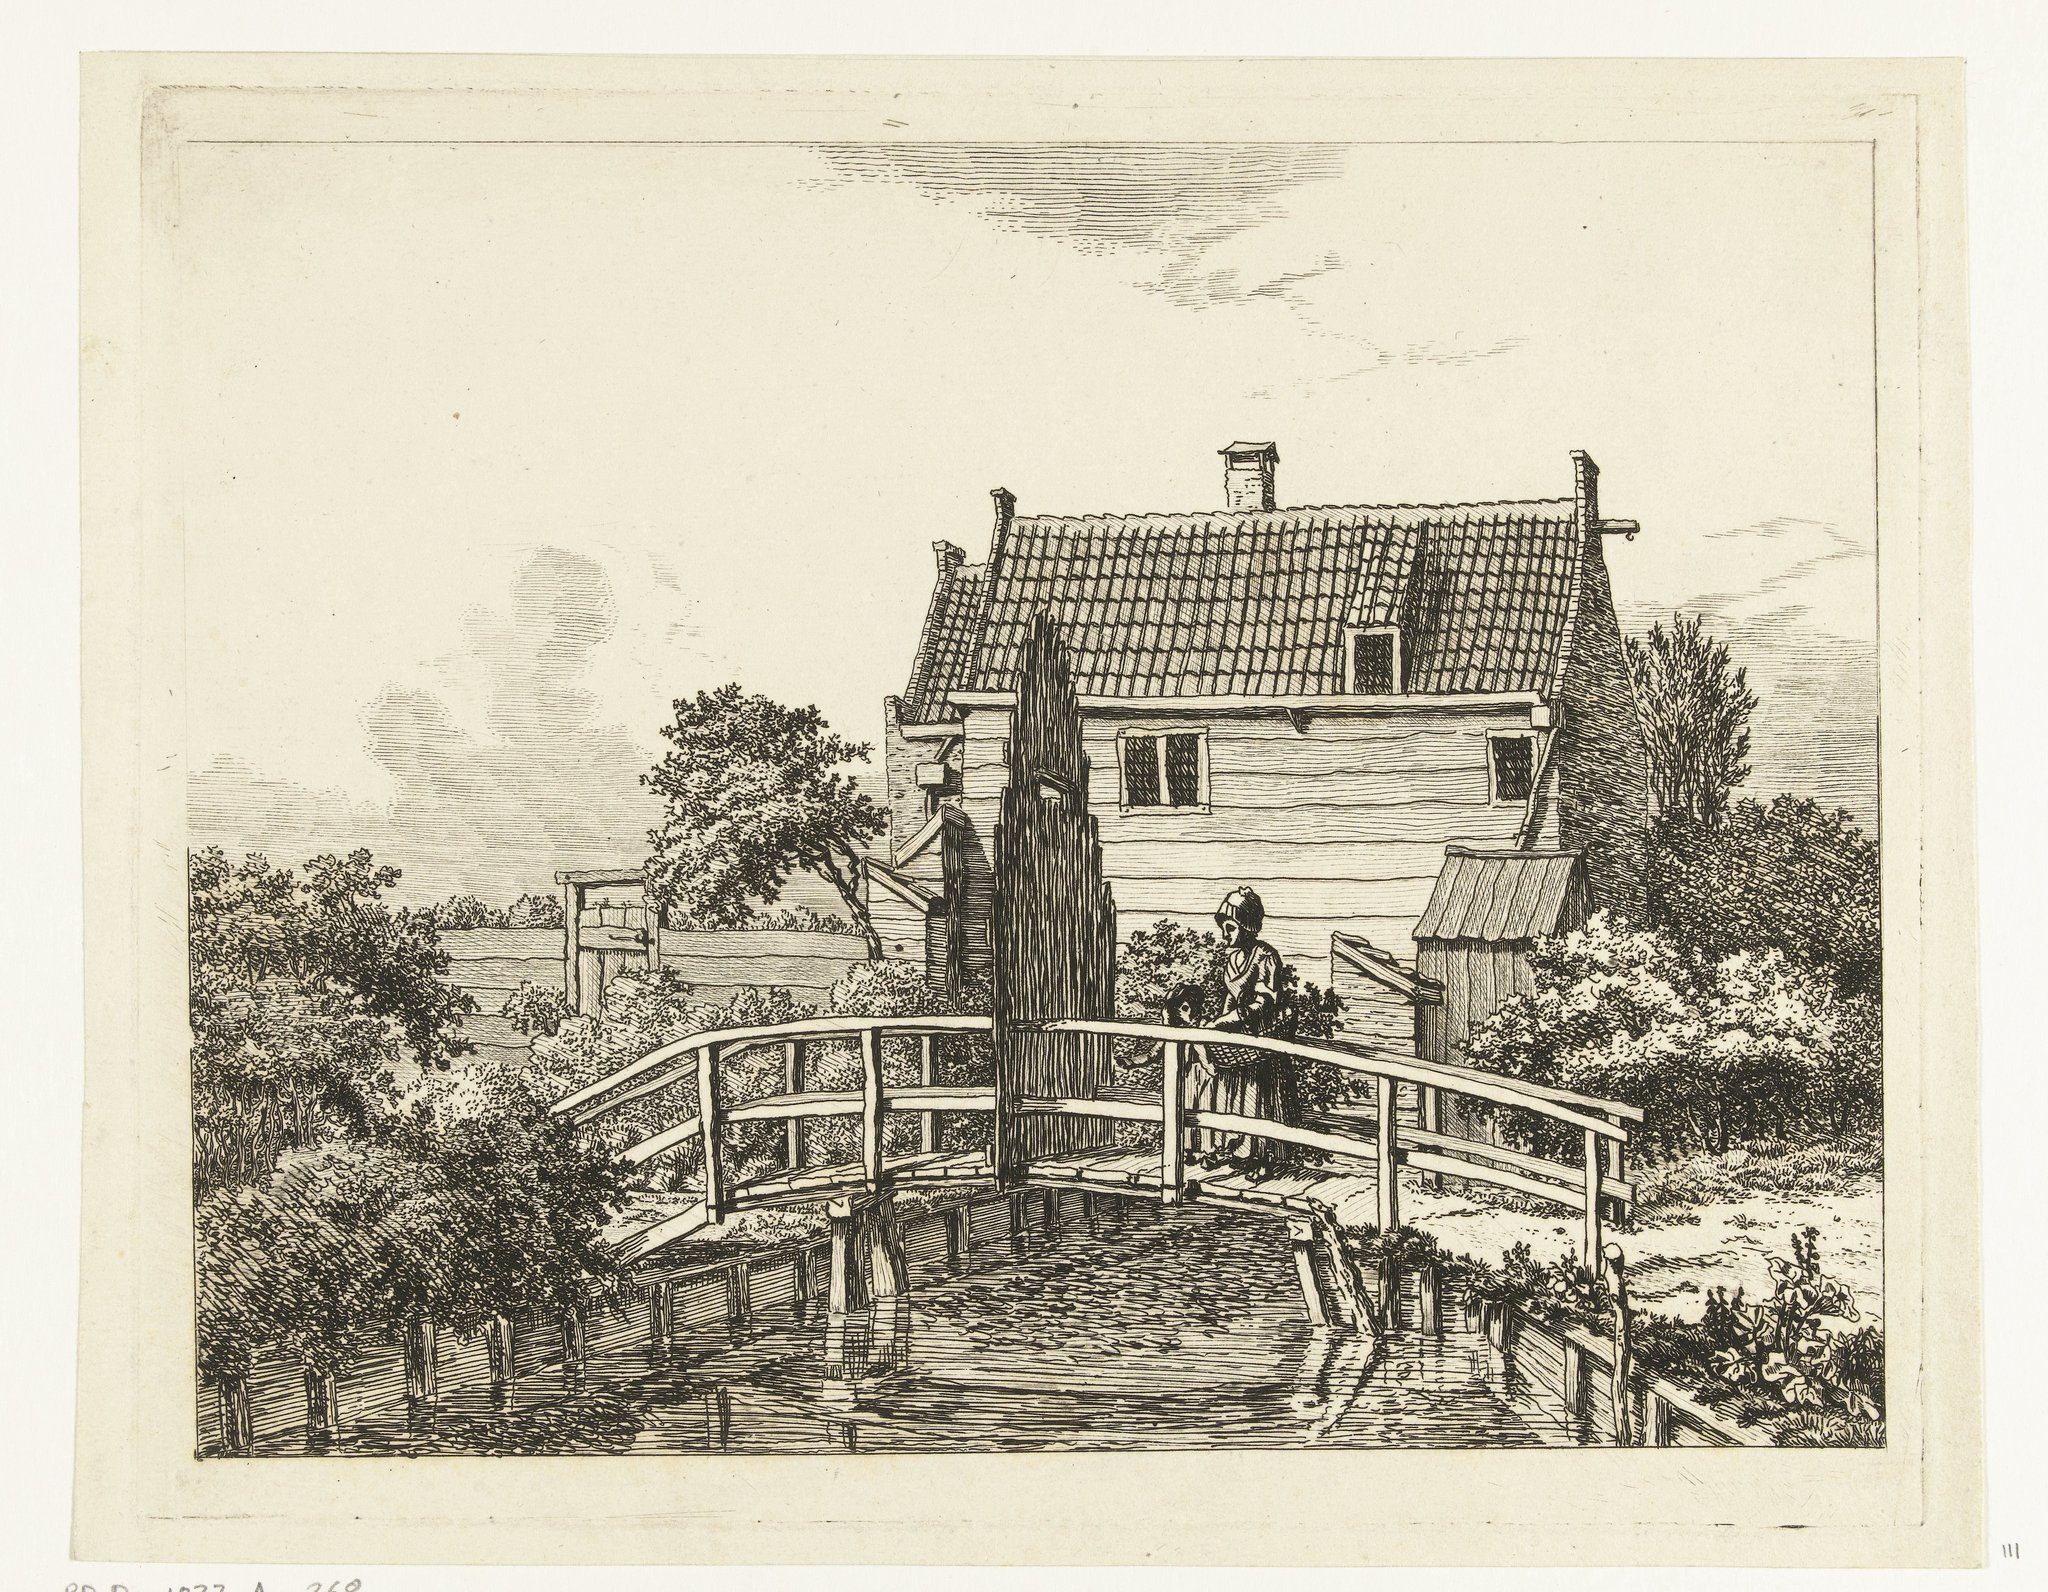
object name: print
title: Vrouw met kind op een brug bij een gesloten hek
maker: anthonie van den bos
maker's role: draughtsman, print maker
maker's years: 1763-1838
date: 1778-1838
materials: paper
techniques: etching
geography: netherlands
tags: bridge with structure, i.e. cover or buildings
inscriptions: signature: ‘naar het leven AVB’, collector's mark: Lugt 2228